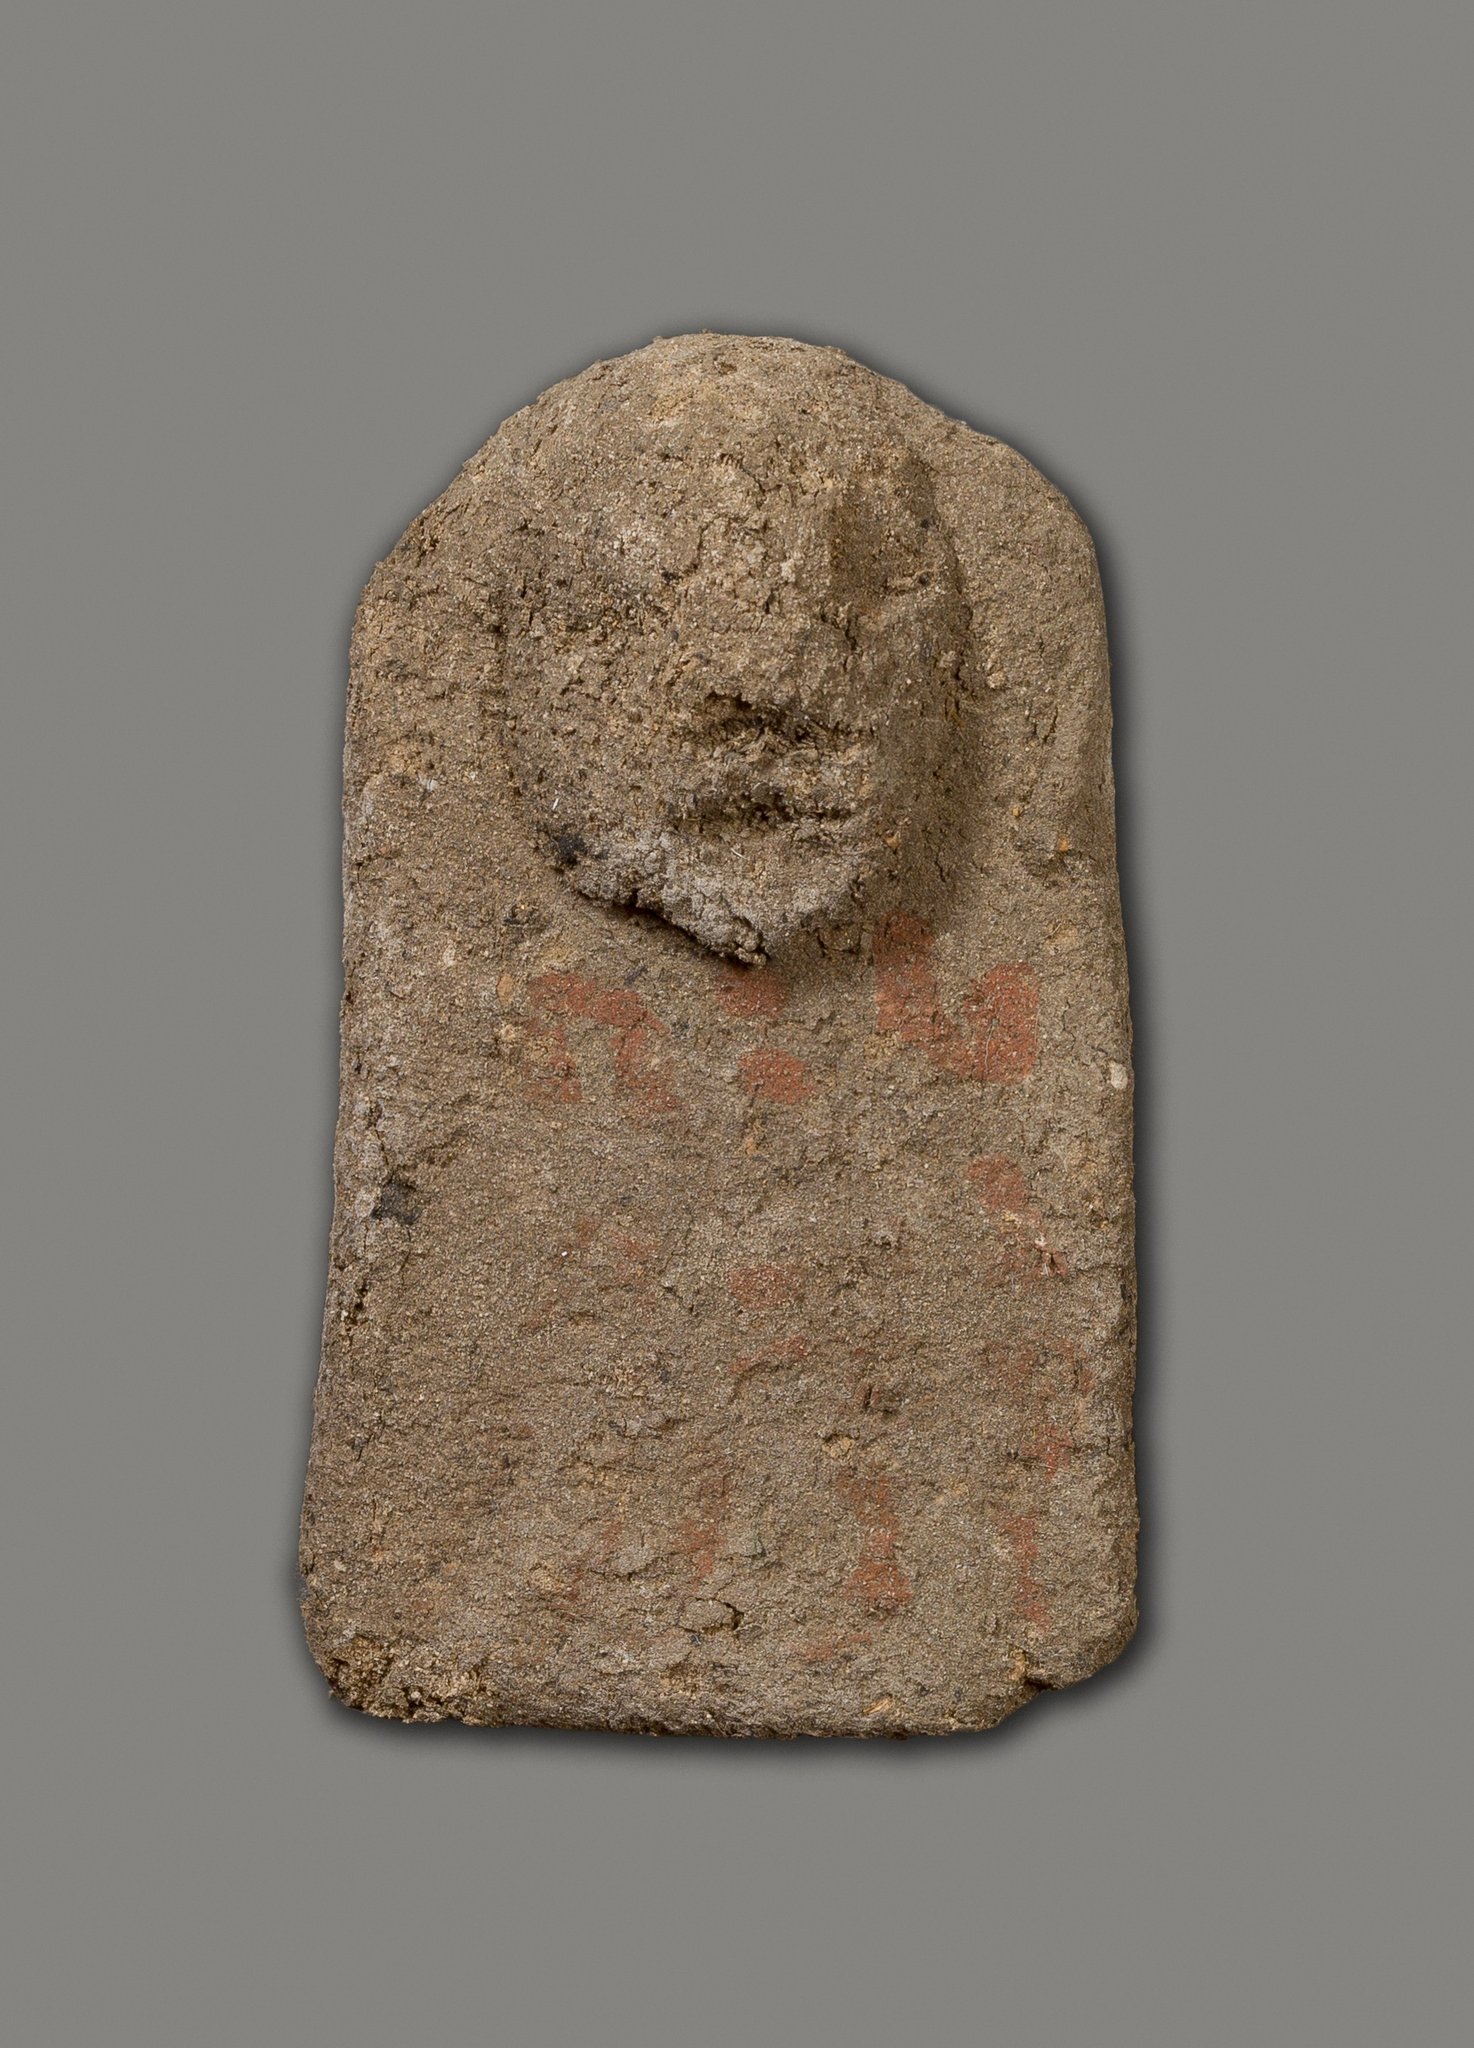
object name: figure, magical, execration, tablet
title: Magical Figure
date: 1802-1550 BCE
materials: clay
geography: egypt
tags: faces